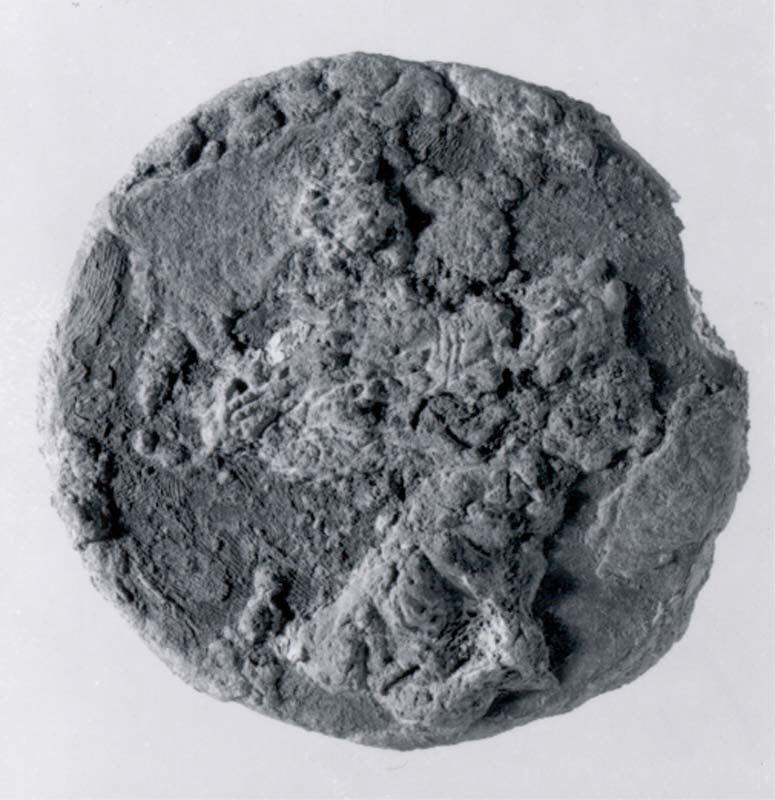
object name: dish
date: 4000-3001 BCE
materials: bronze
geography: mesopotamia